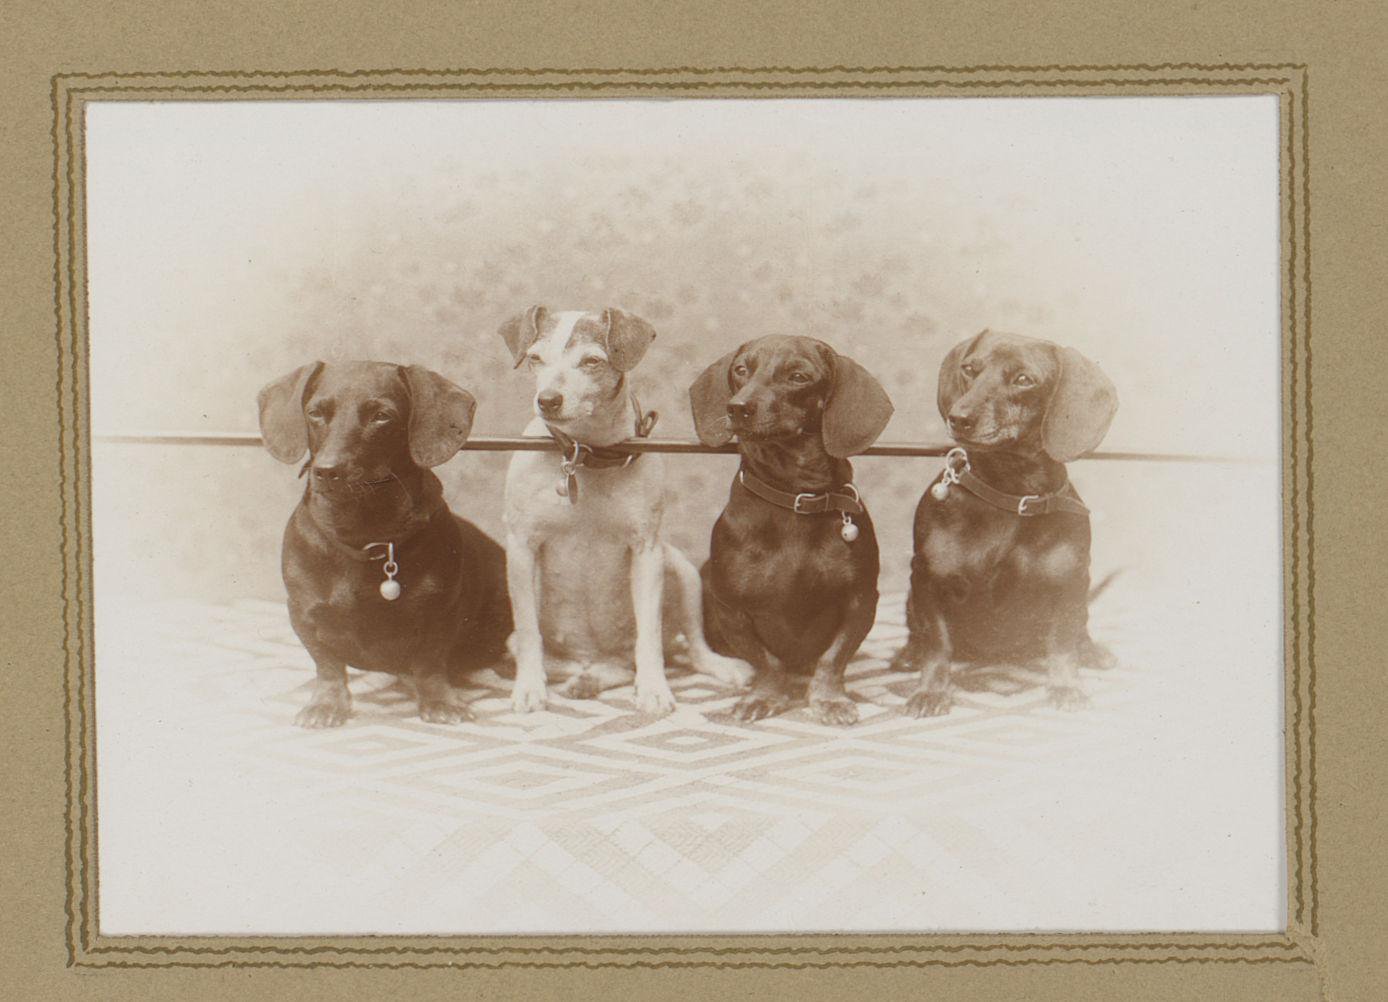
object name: cabinet photograph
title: Vier honden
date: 1857-1908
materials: cardboard, photographic support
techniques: albumen print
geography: amsterdam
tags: dog